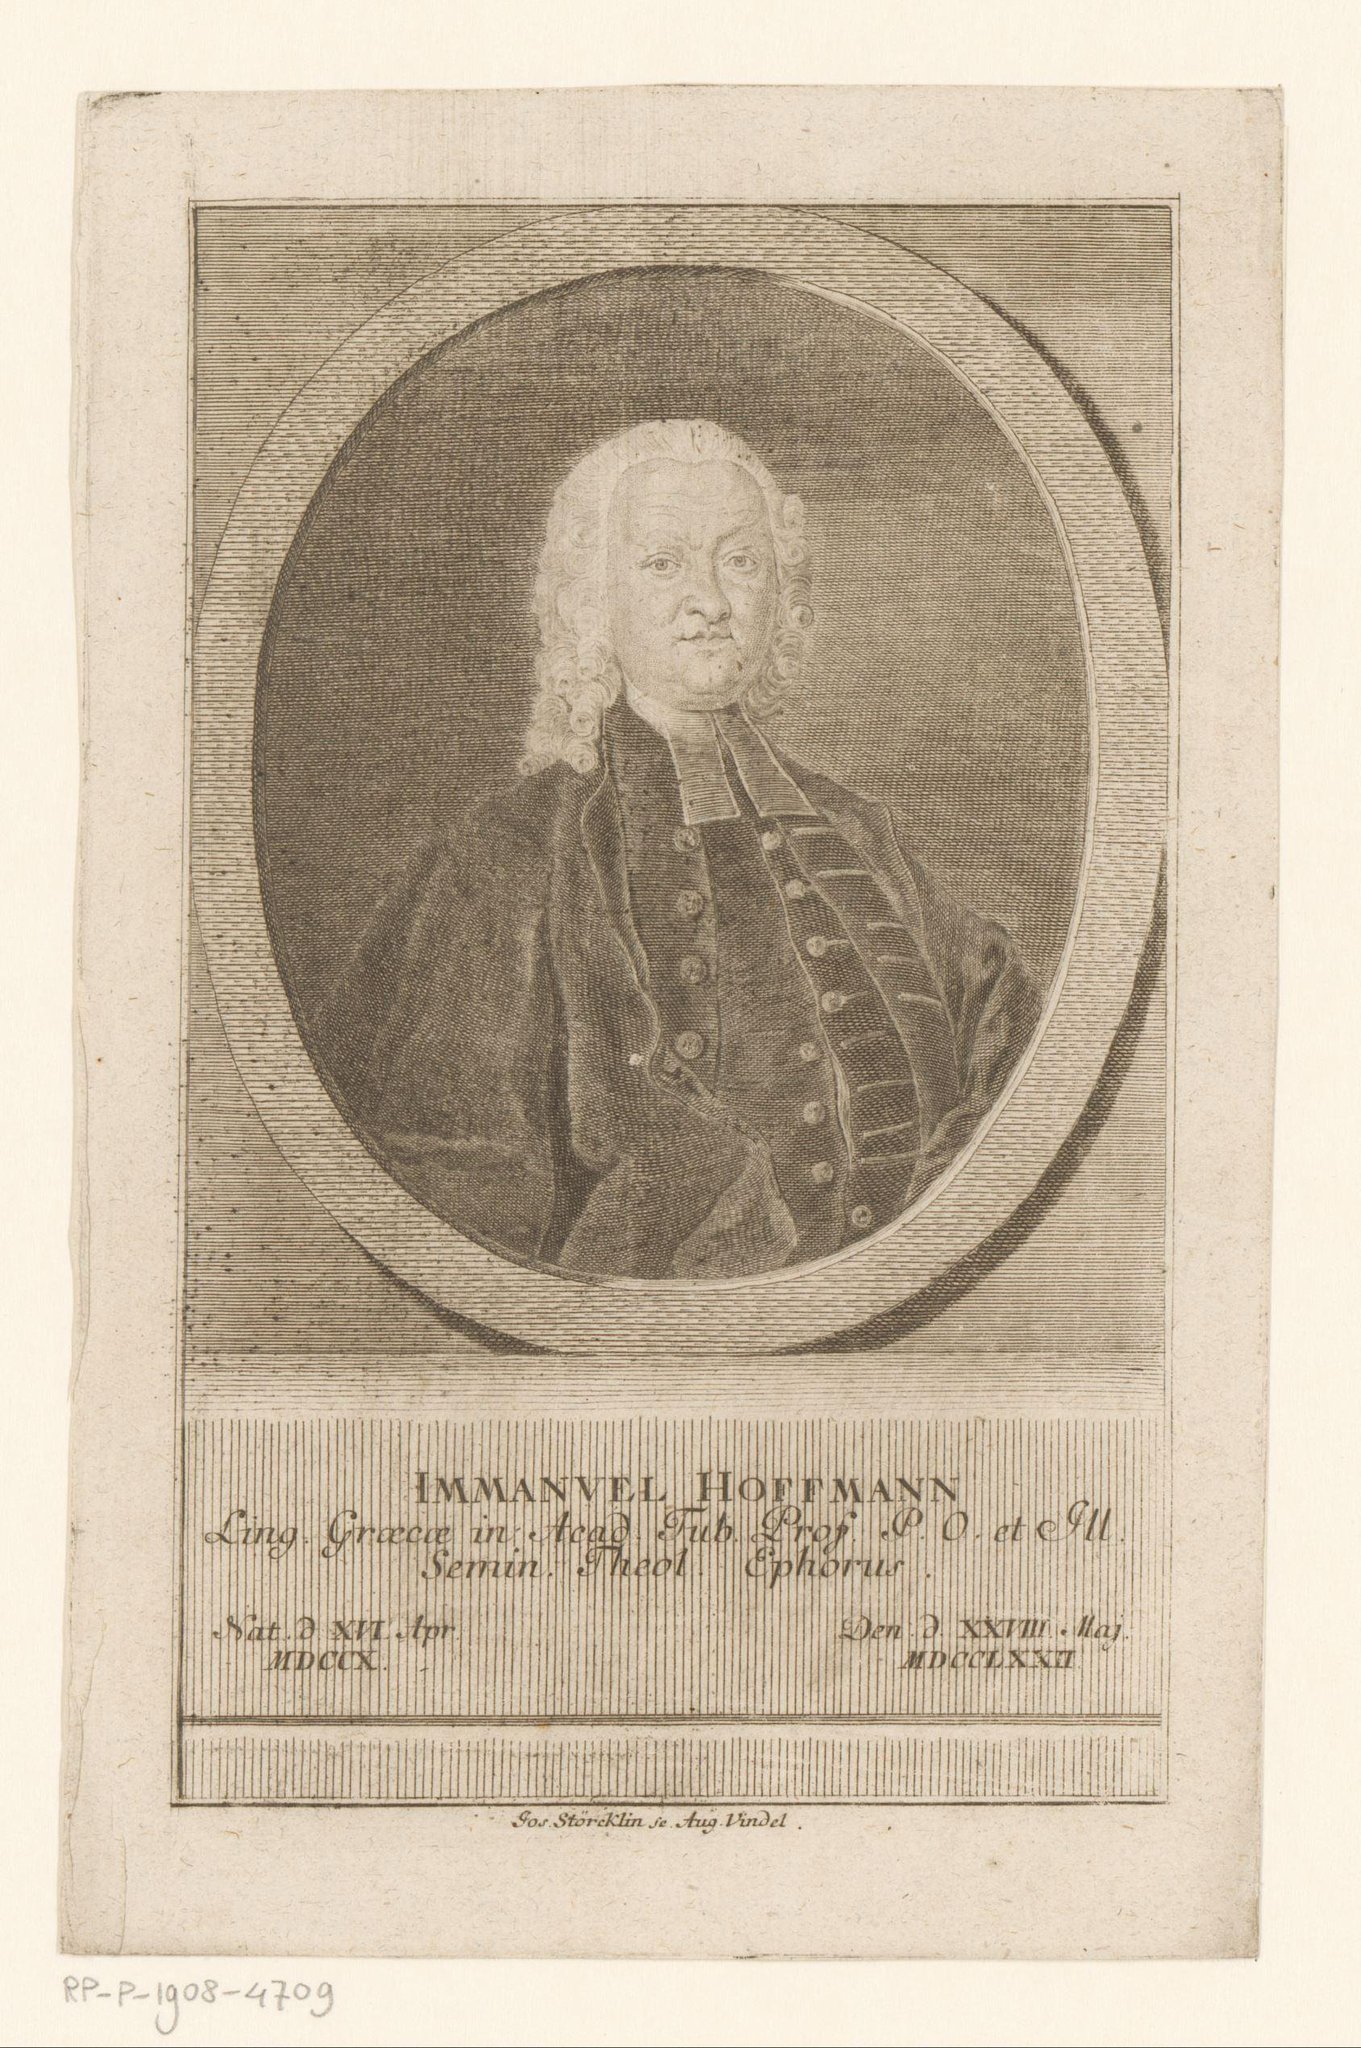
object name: print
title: Portret van Immanuel Hoffmann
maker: johann joseph störchlin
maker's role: print maker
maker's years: -1778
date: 1772-1778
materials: paper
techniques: engraving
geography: augsburg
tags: historical persons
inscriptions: collector's mark: Lugt 2228